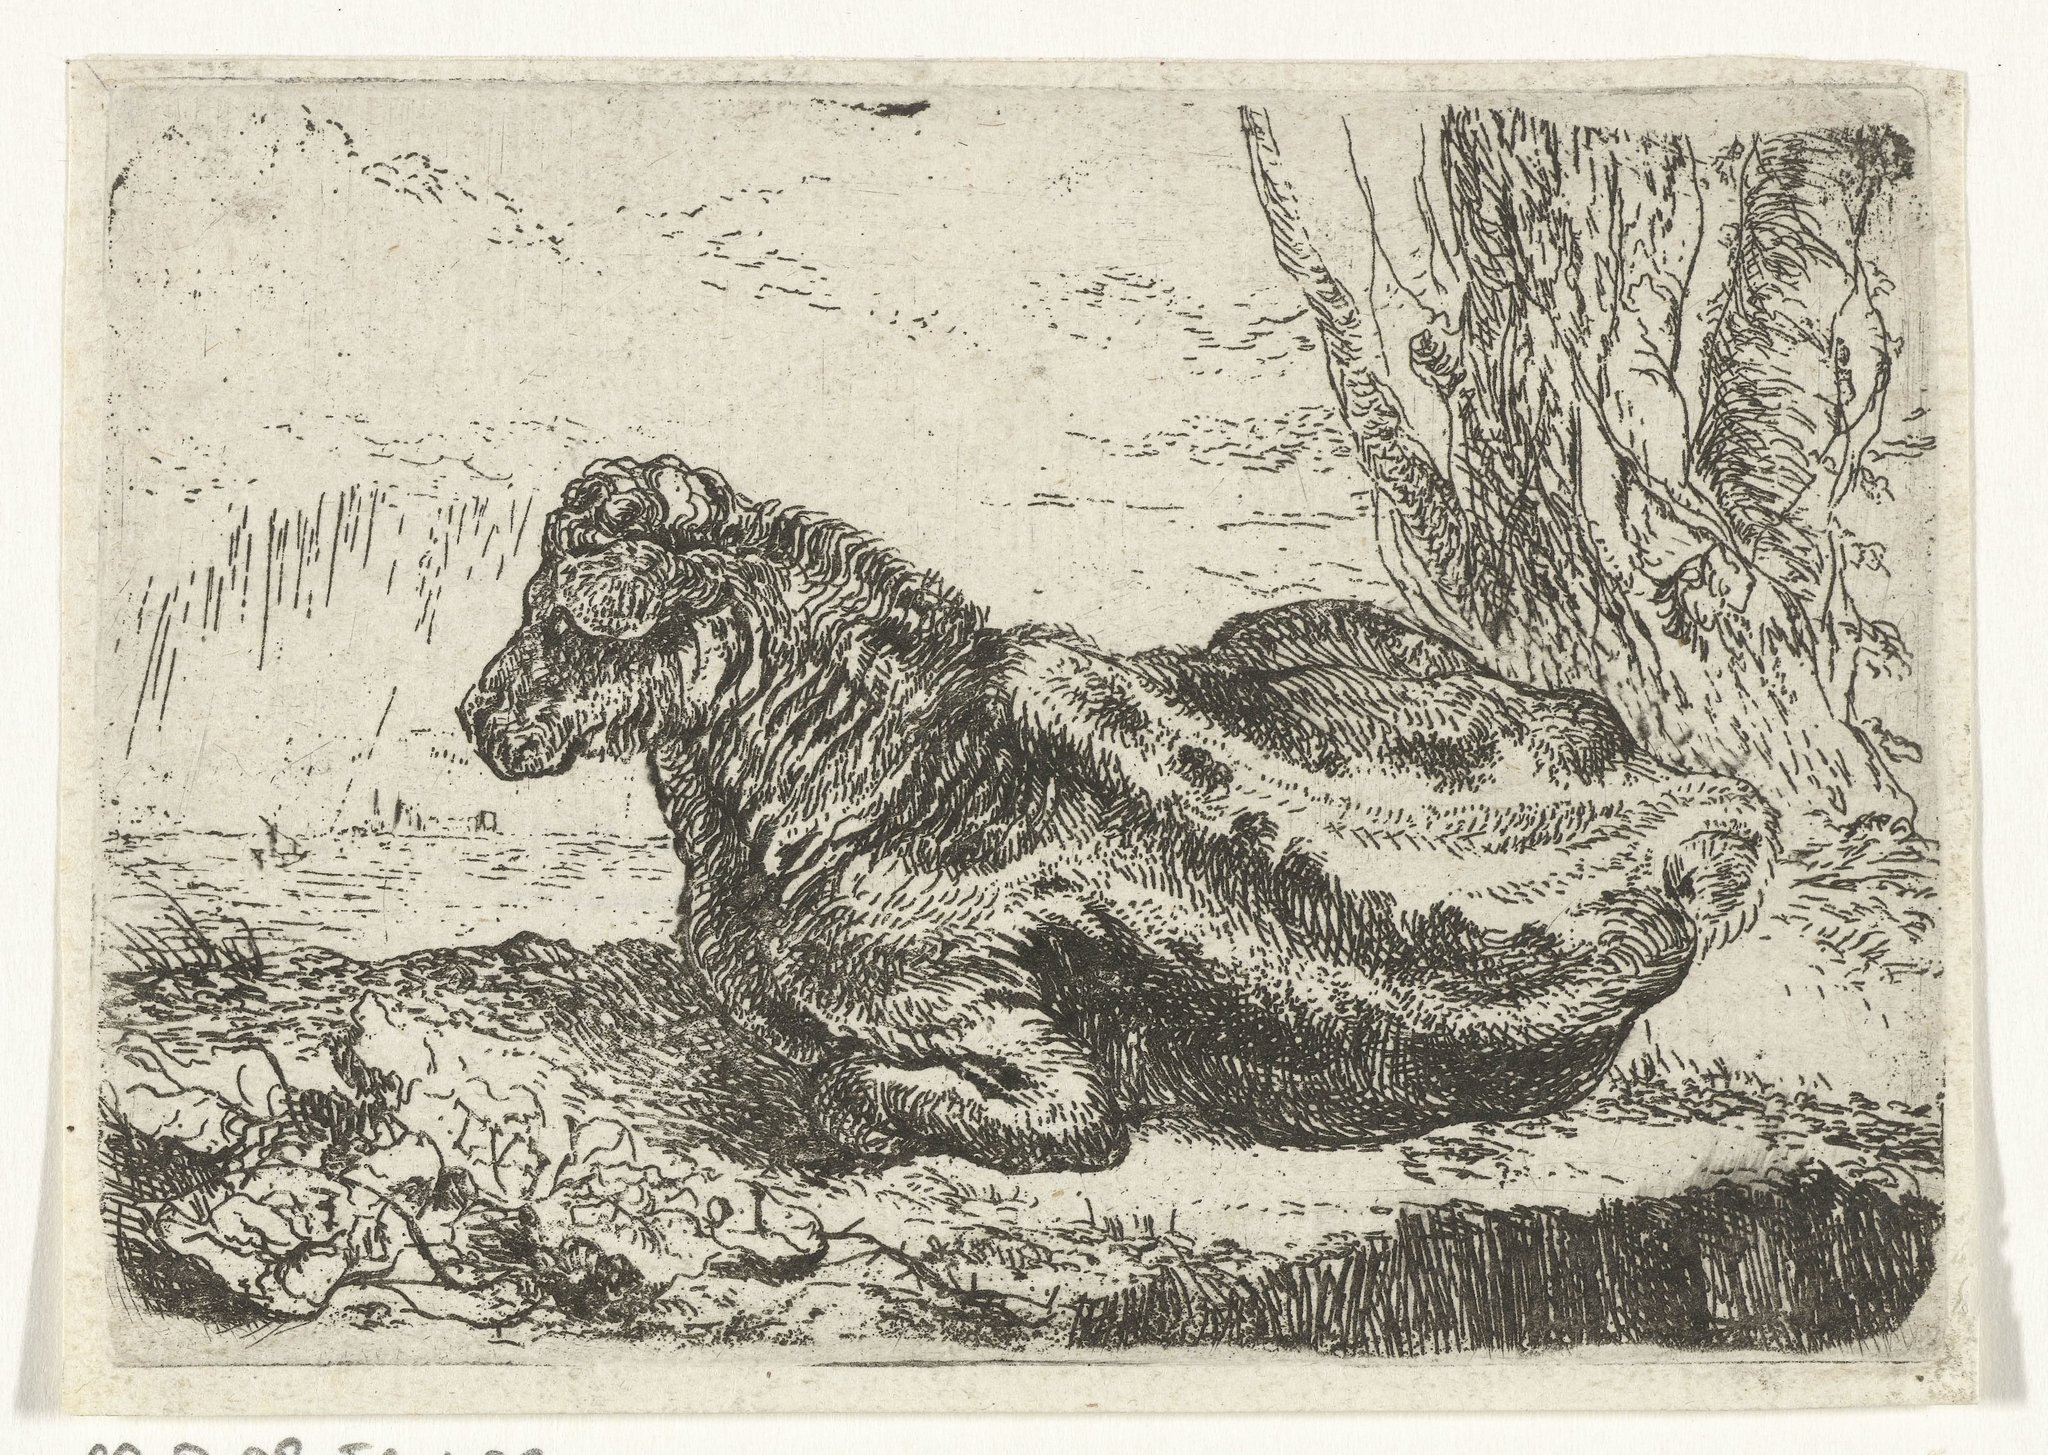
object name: print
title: Koe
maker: joannes fijt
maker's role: draughtsman, print maker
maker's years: 1611-1661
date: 1621-1661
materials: paper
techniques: etching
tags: cow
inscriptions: collector's mark: Lugt 2228